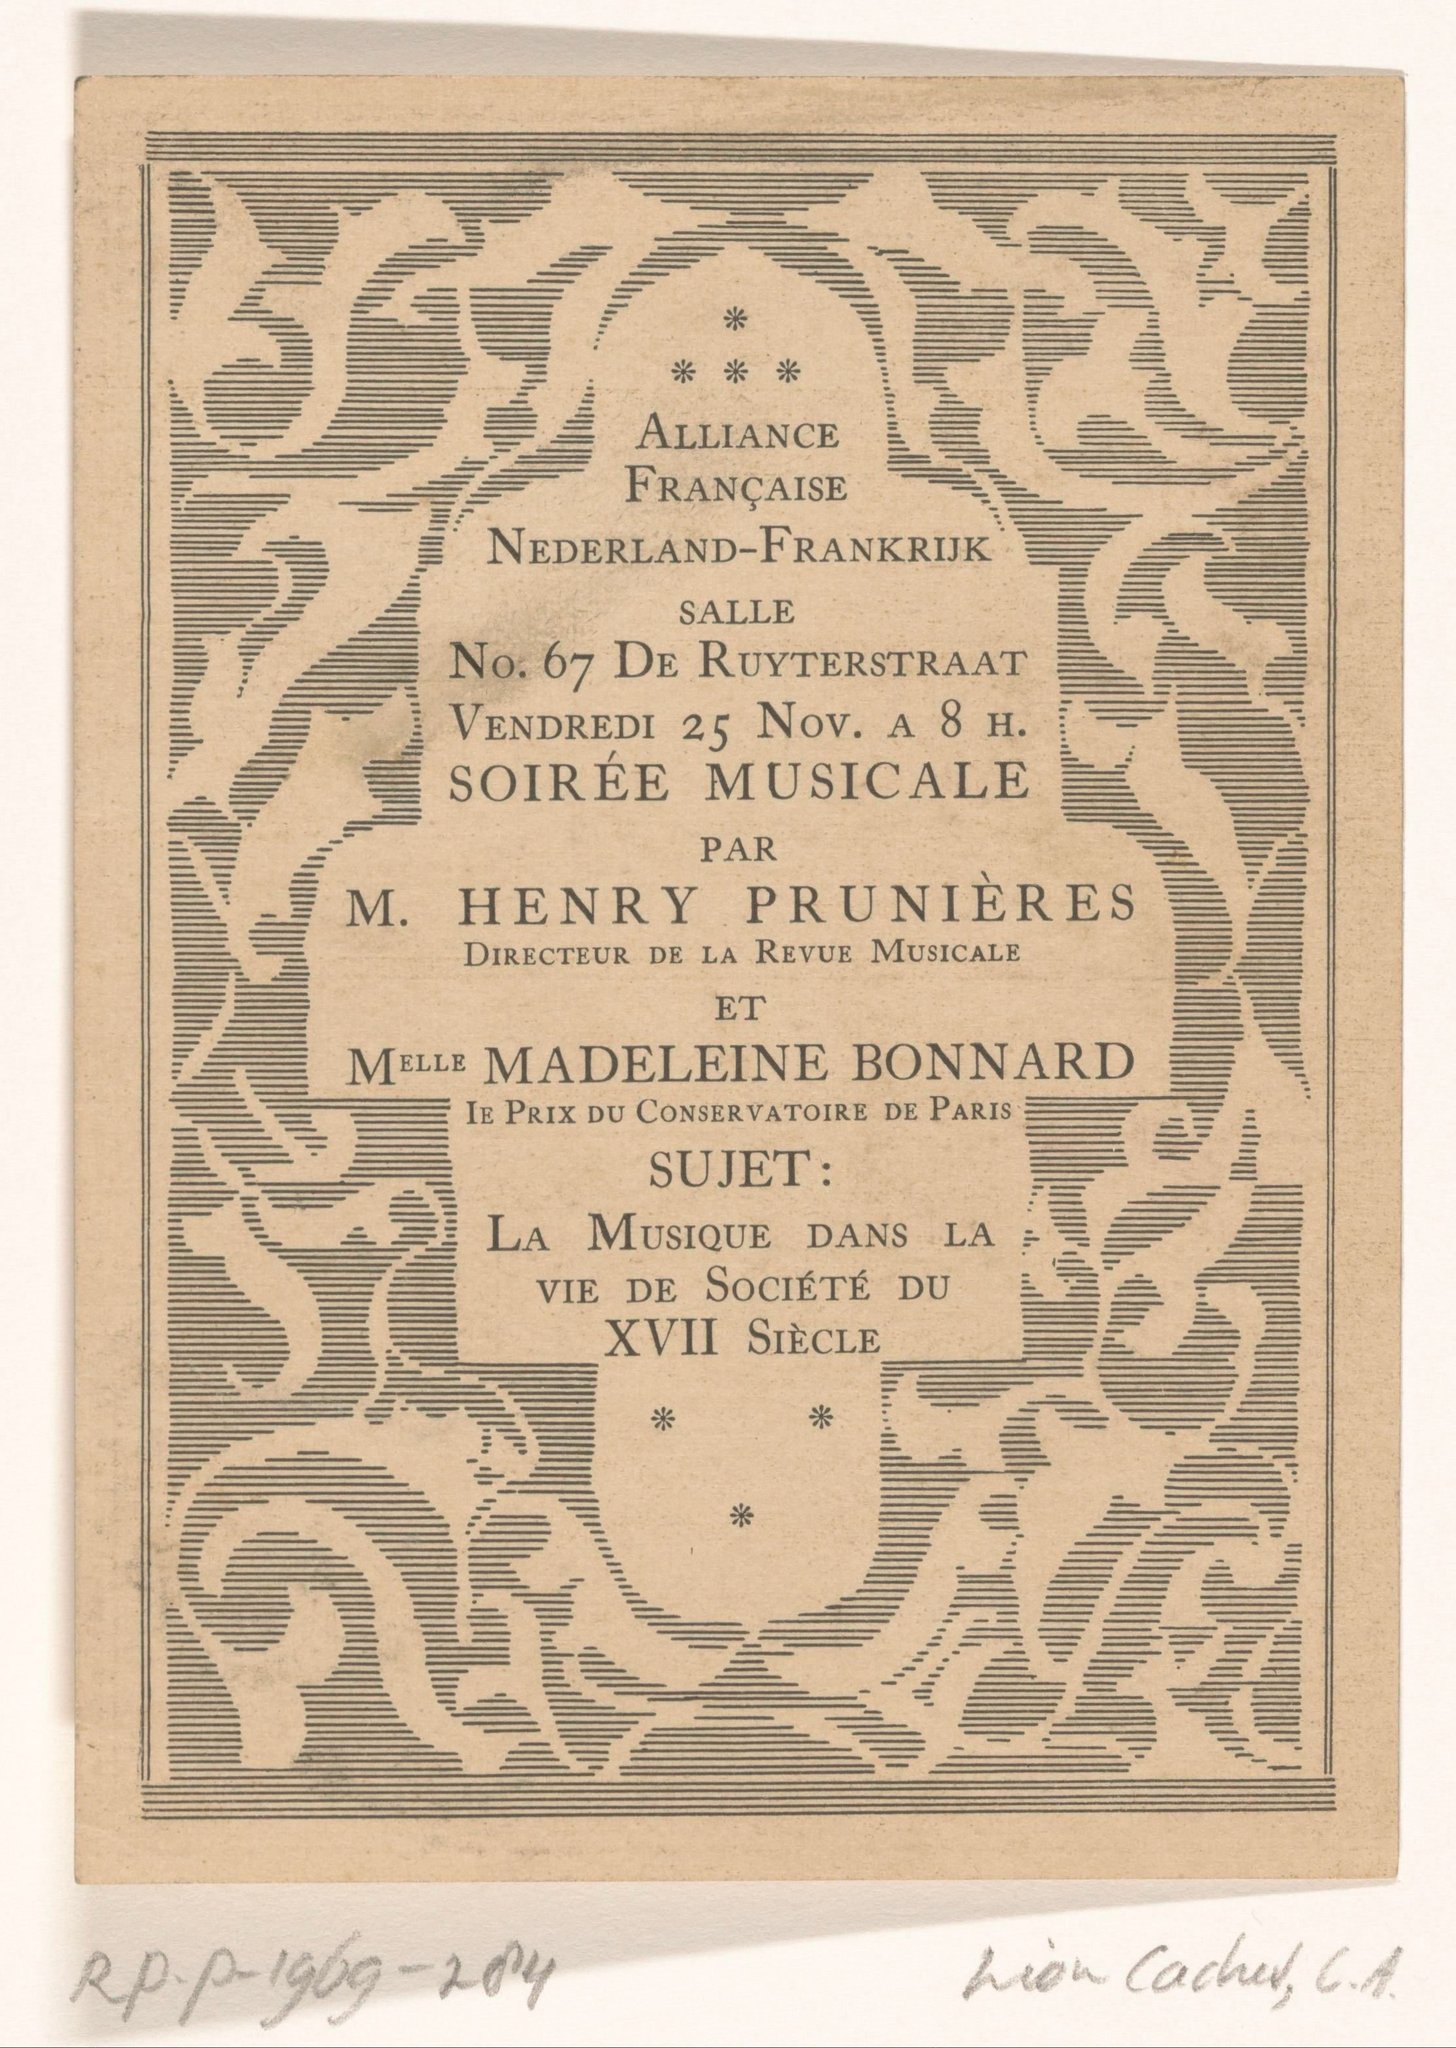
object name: postcard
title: Aankondiging voor muziekavond van de Alliance Française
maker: carel adolph lion cachet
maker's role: draughtsman, print maker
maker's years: 1864-1945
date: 1874-1945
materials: paper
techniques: letterpress printing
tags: paris, music, ornament derived from plant forms - aa - stylized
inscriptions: collector's mark: Lugt 2228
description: Een gestreept patroon met gestileerde plantmotieven met in het midden een uitsparing. Daarin staat de aankondiging van een muziekavond over muziek in de zeventiende eeuw.